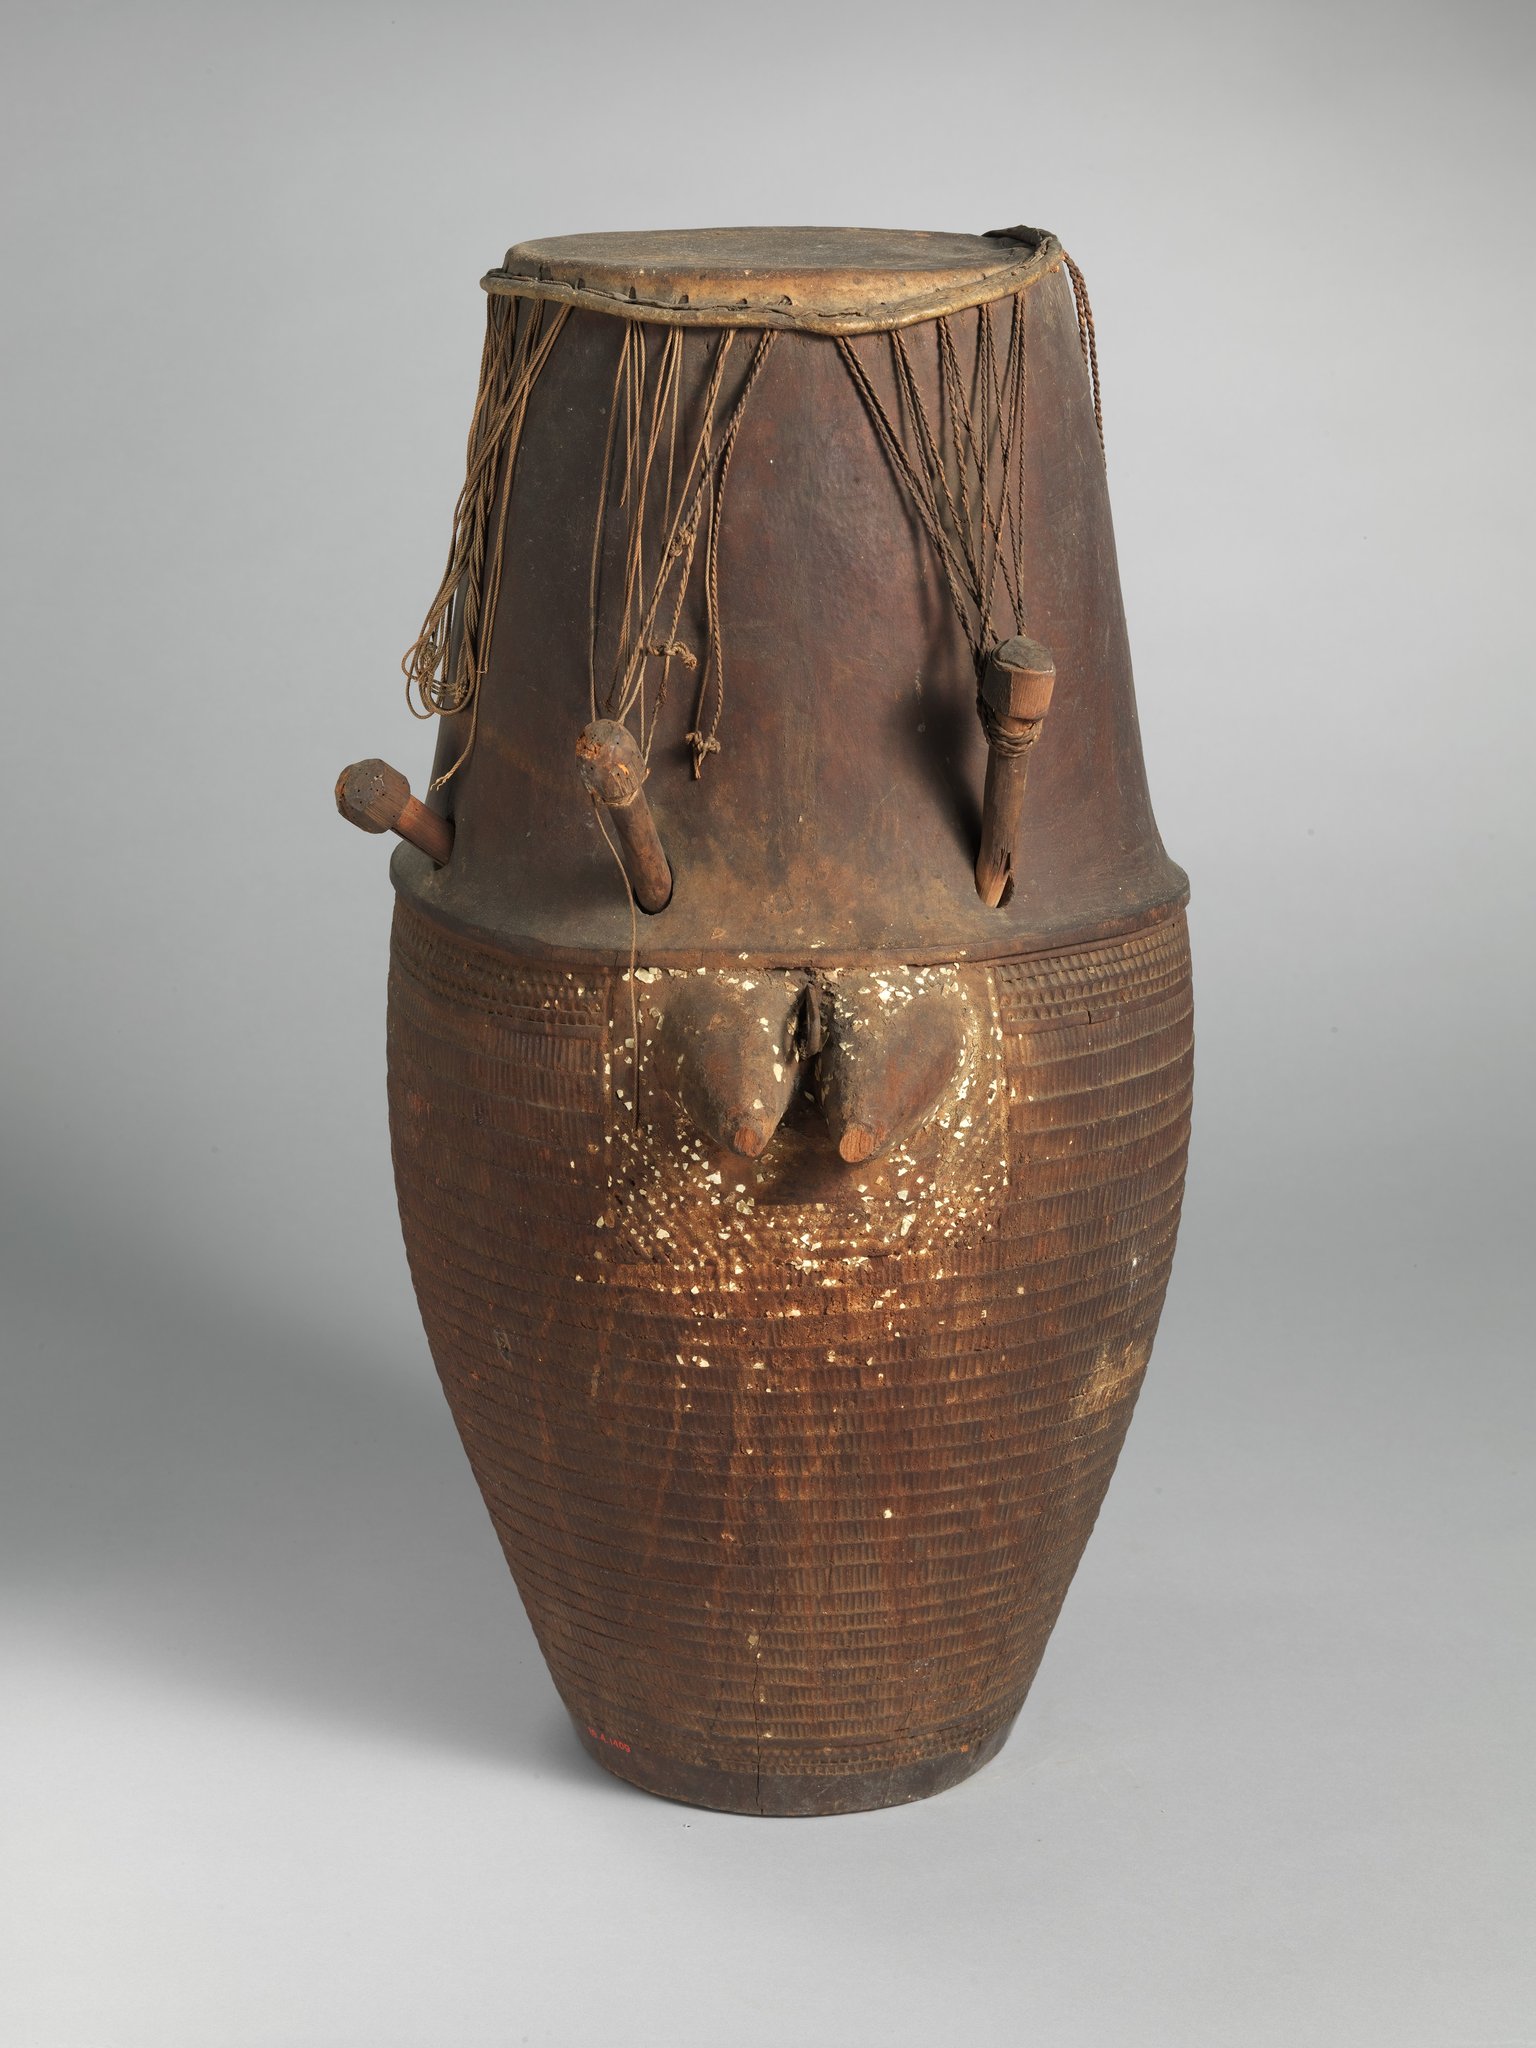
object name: breasted drum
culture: akan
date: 1801-1900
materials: wood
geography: ghana